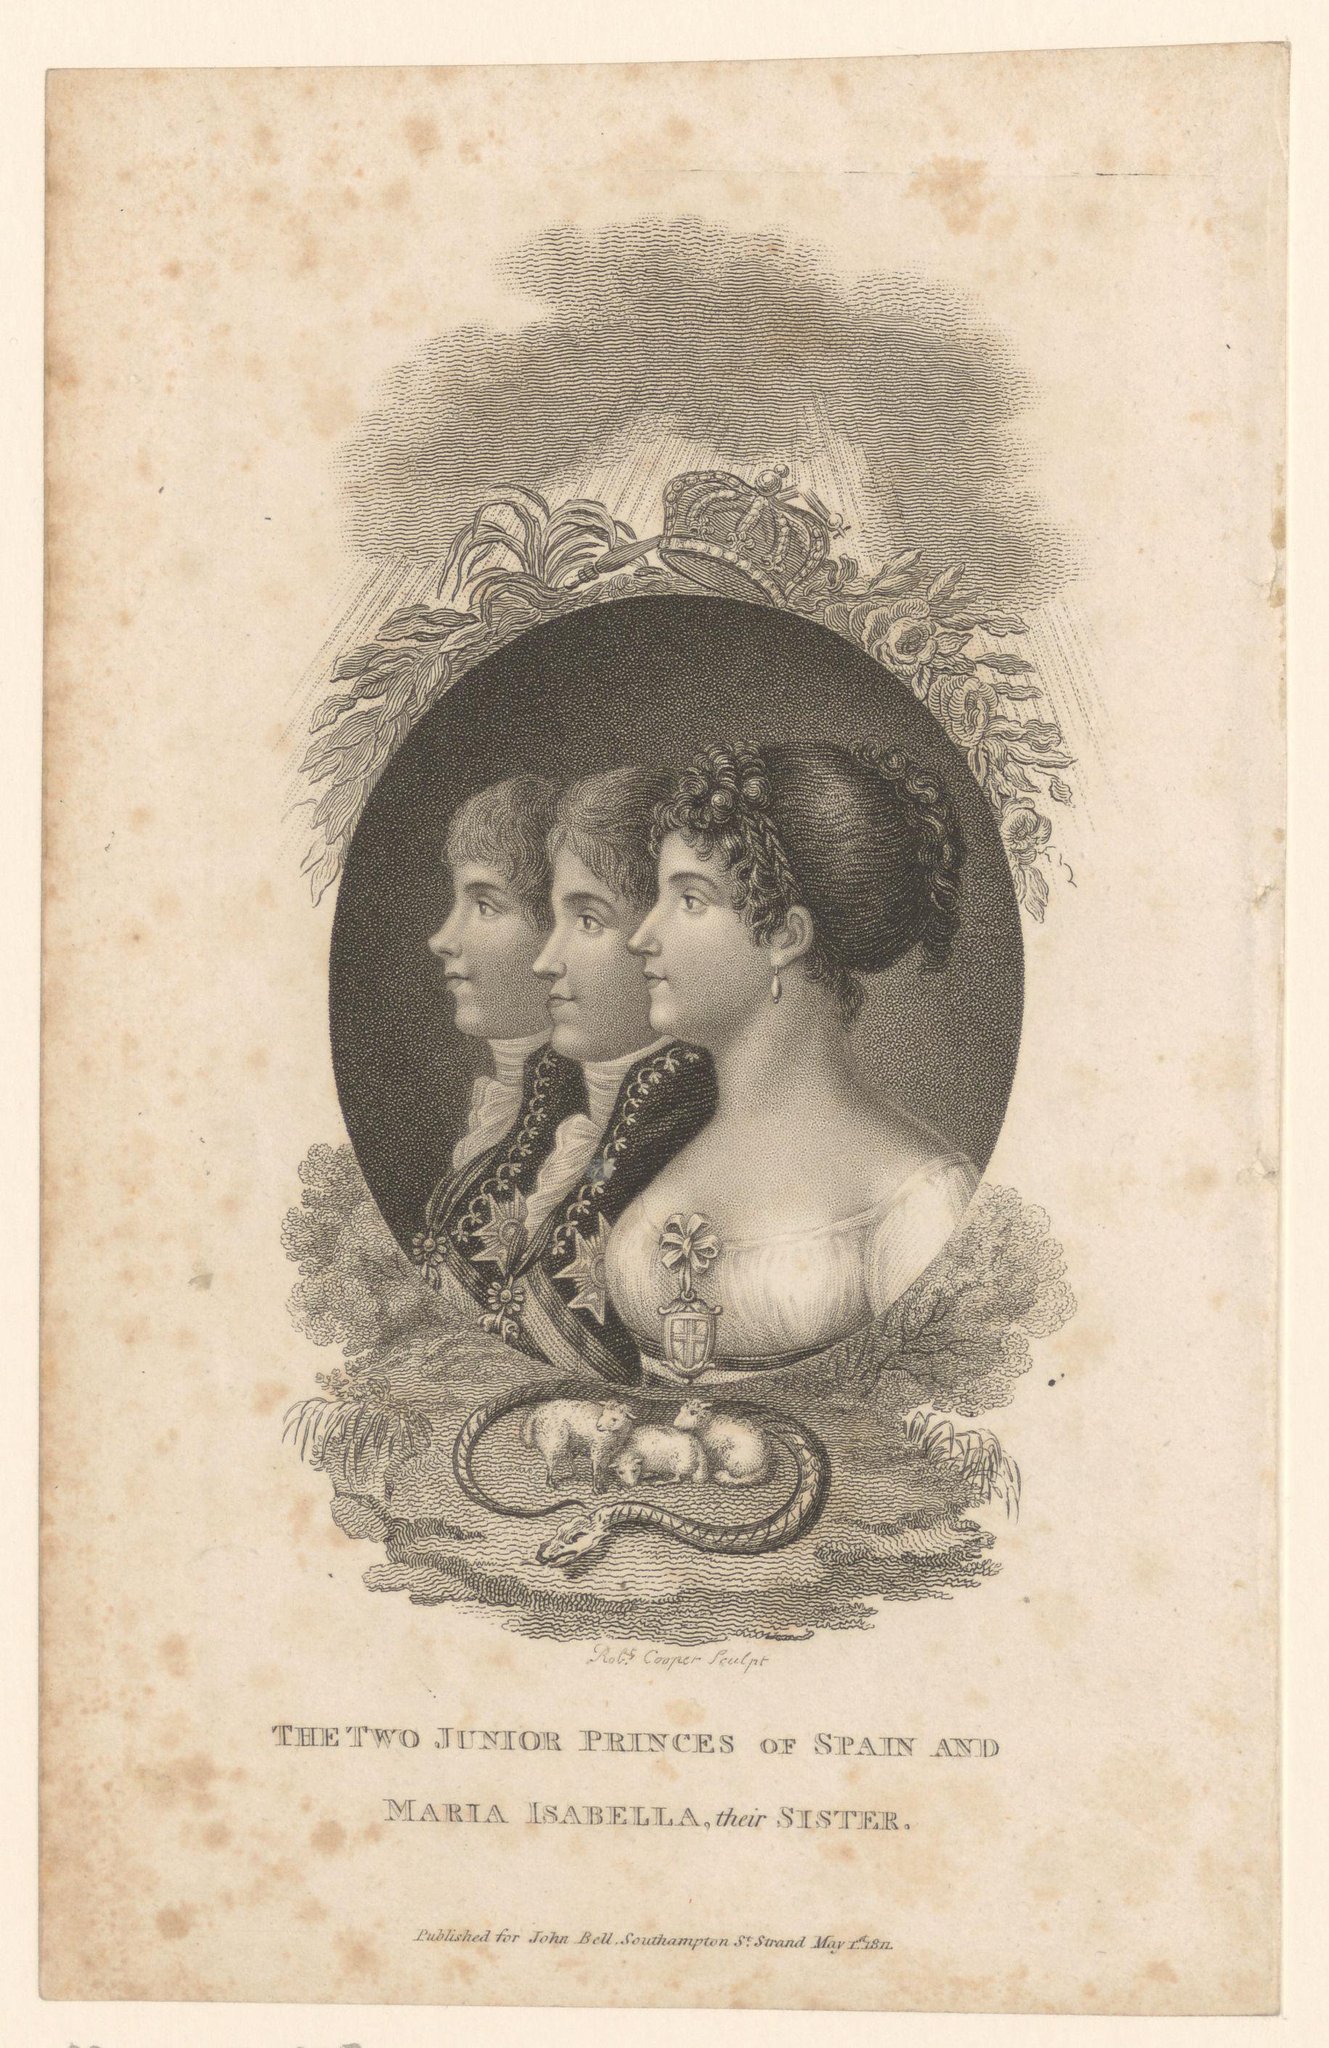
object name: print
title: The Two Junior Princes of Spain and Maria Isabella, their Sister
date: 1805-1811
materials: paper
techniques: etching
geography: london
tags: earl, prince, historical persons, brothers or sisters (second degree family relationships)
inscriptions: collector's mark: Lugt 2228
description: Prent uit: La Belle assemblée: or Bell's court and fashionable magazine, mei 1811, dl. 18.